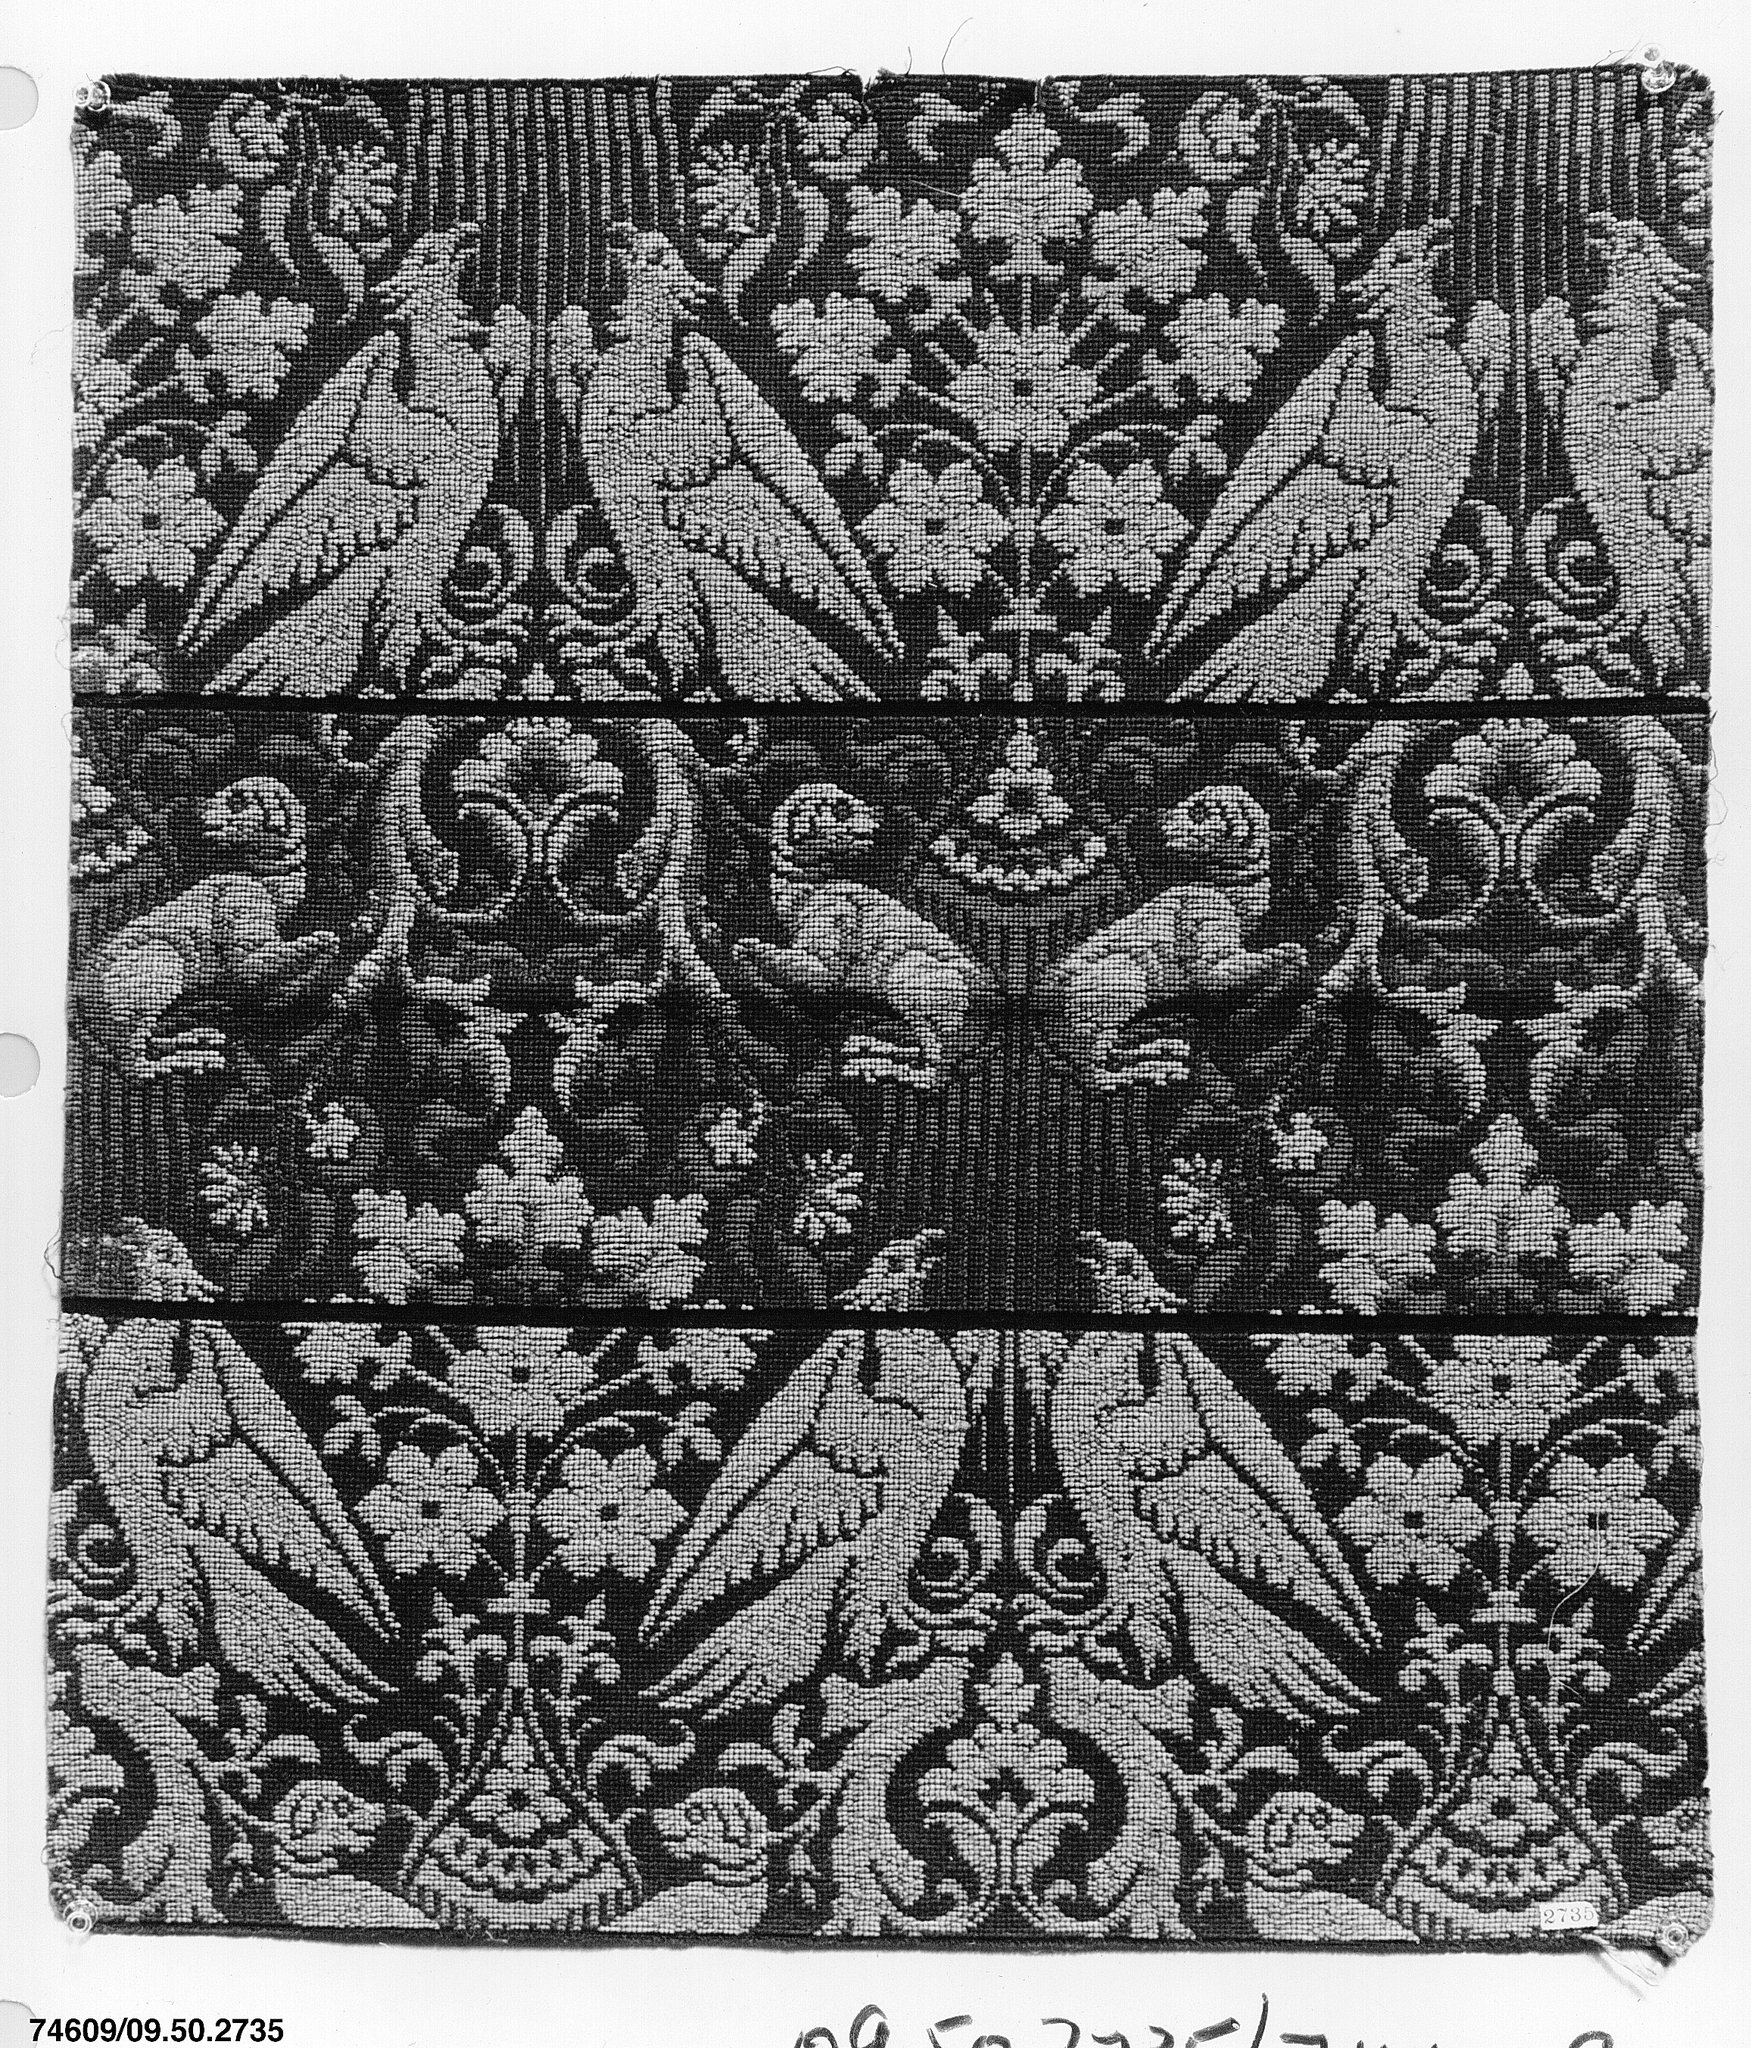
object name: piece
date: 1801-1900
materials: cotton, wool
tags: birds,dogs,flowers